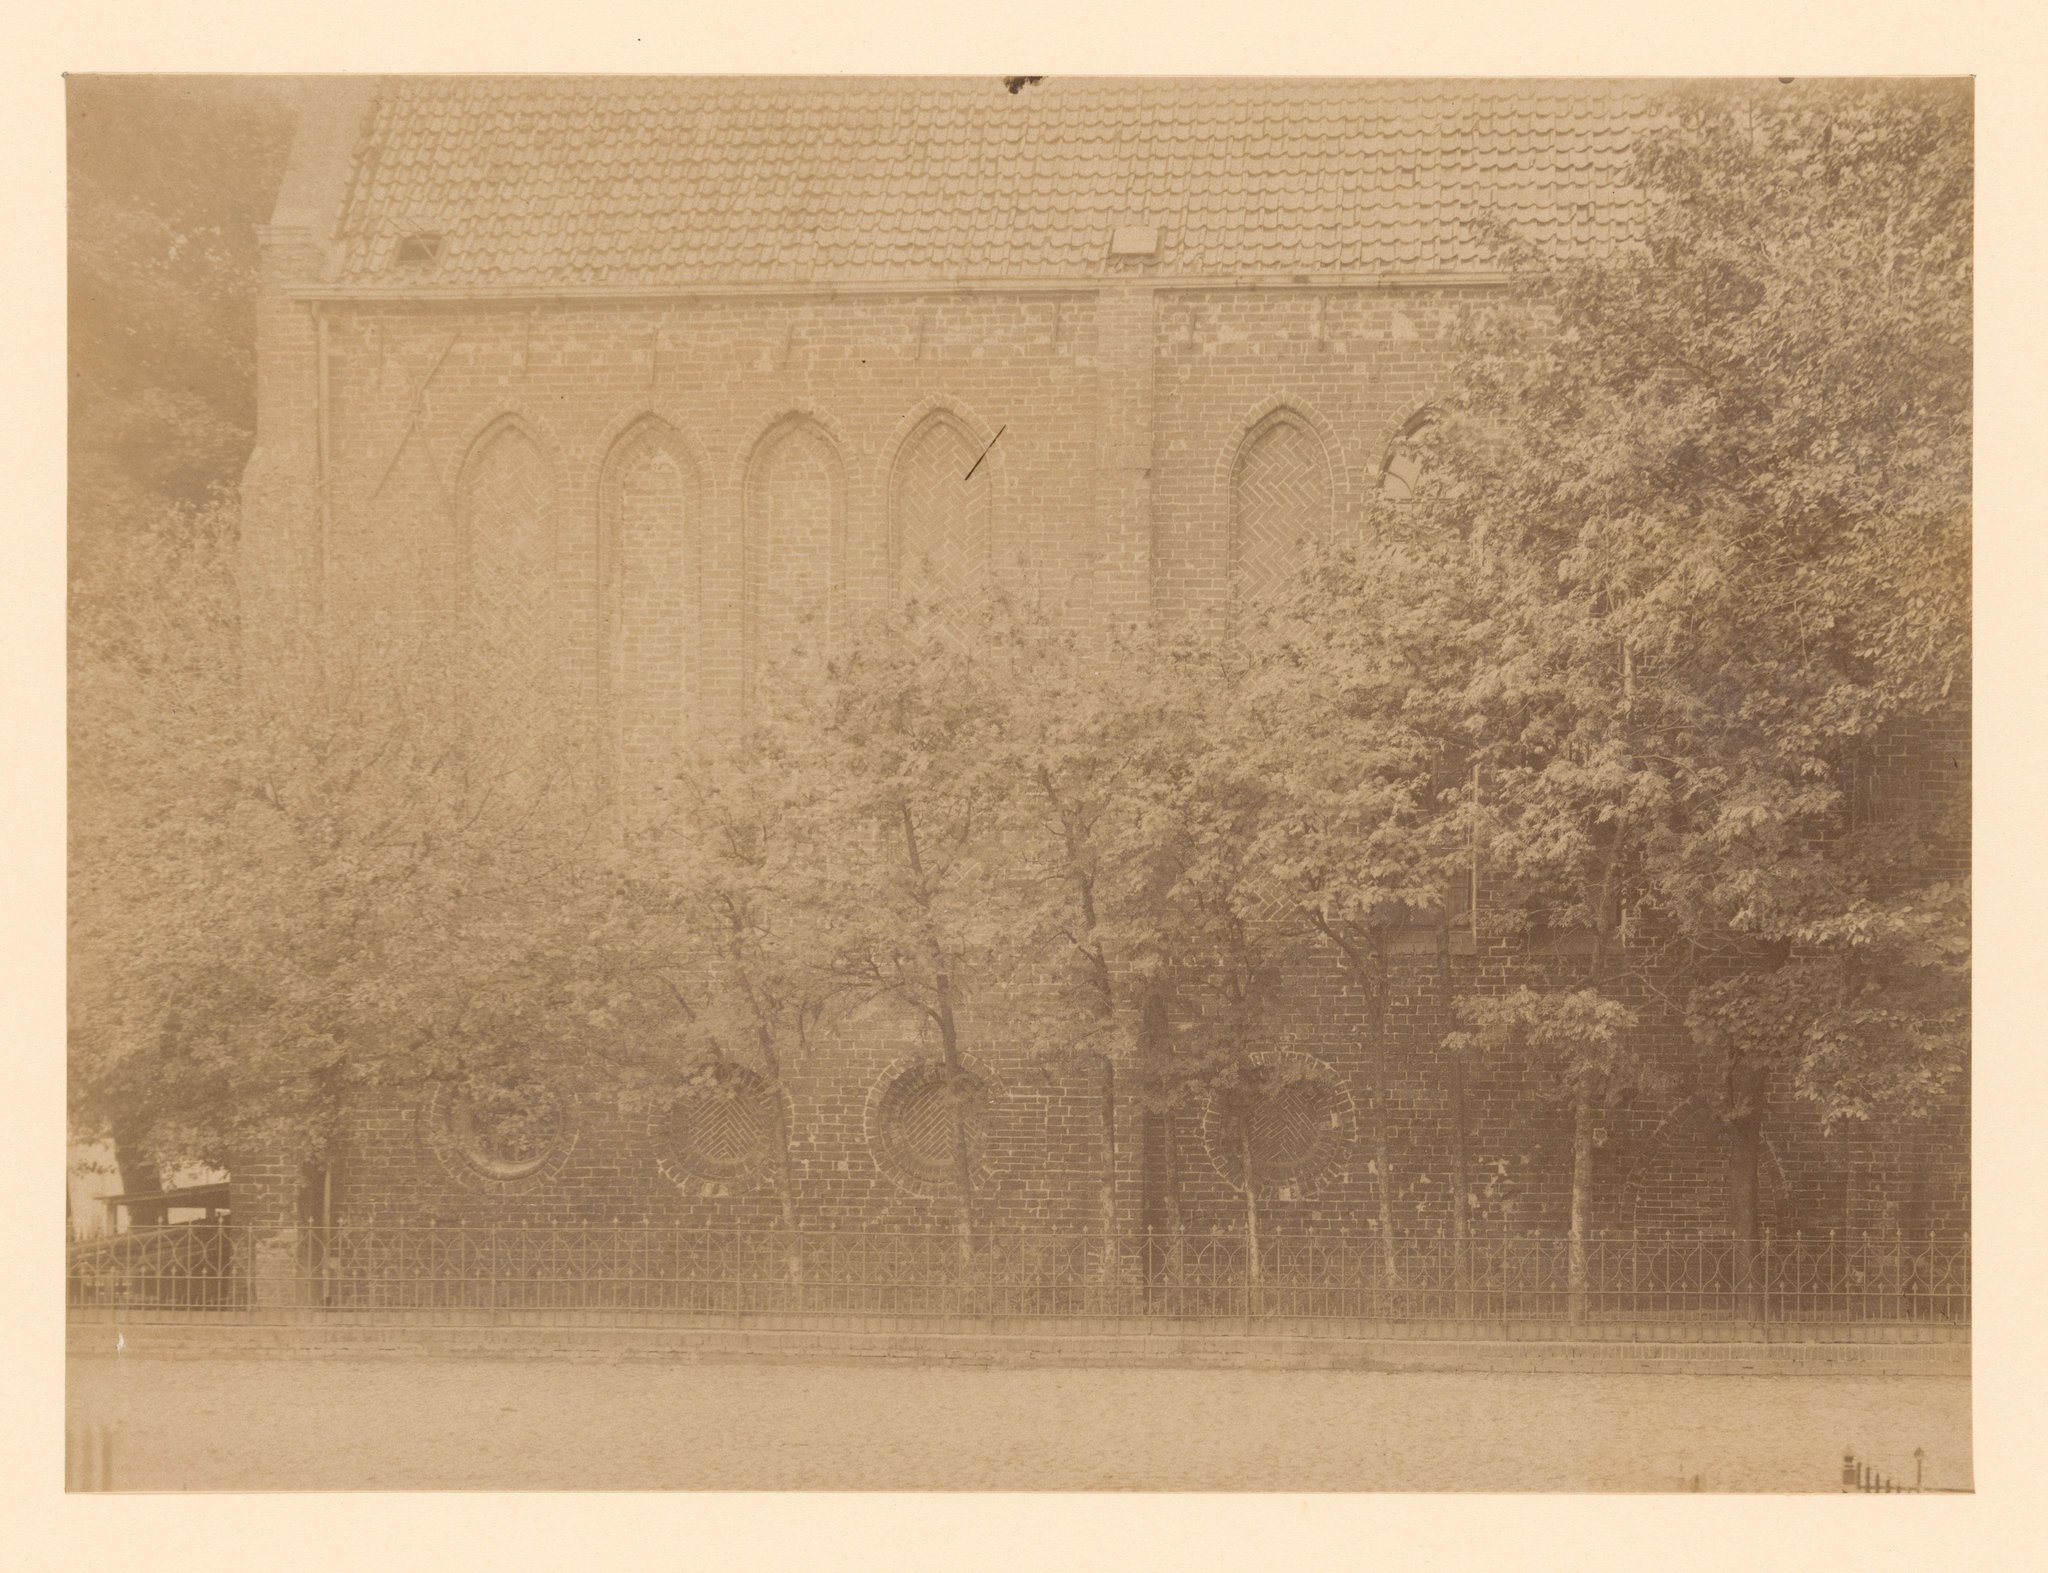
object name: photograph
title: Travee aan de noordzijde van de Marktpleinkerk te Winschoten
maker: anoniem (monumentenzorg)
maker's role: fotograaf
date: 1893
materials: cardboard, photographic support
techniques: albumen print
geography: winschoten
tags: church (exterior)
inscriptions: annotation: ‘Winschoten’, annotation: ‘Winschoten/ Een der Traveën aan de noordzijde der N.H. kerk/ sept 1893’